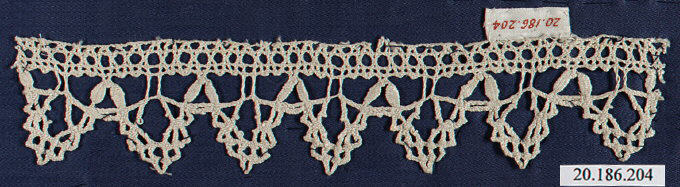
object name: edging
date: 1601-1700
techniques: lace